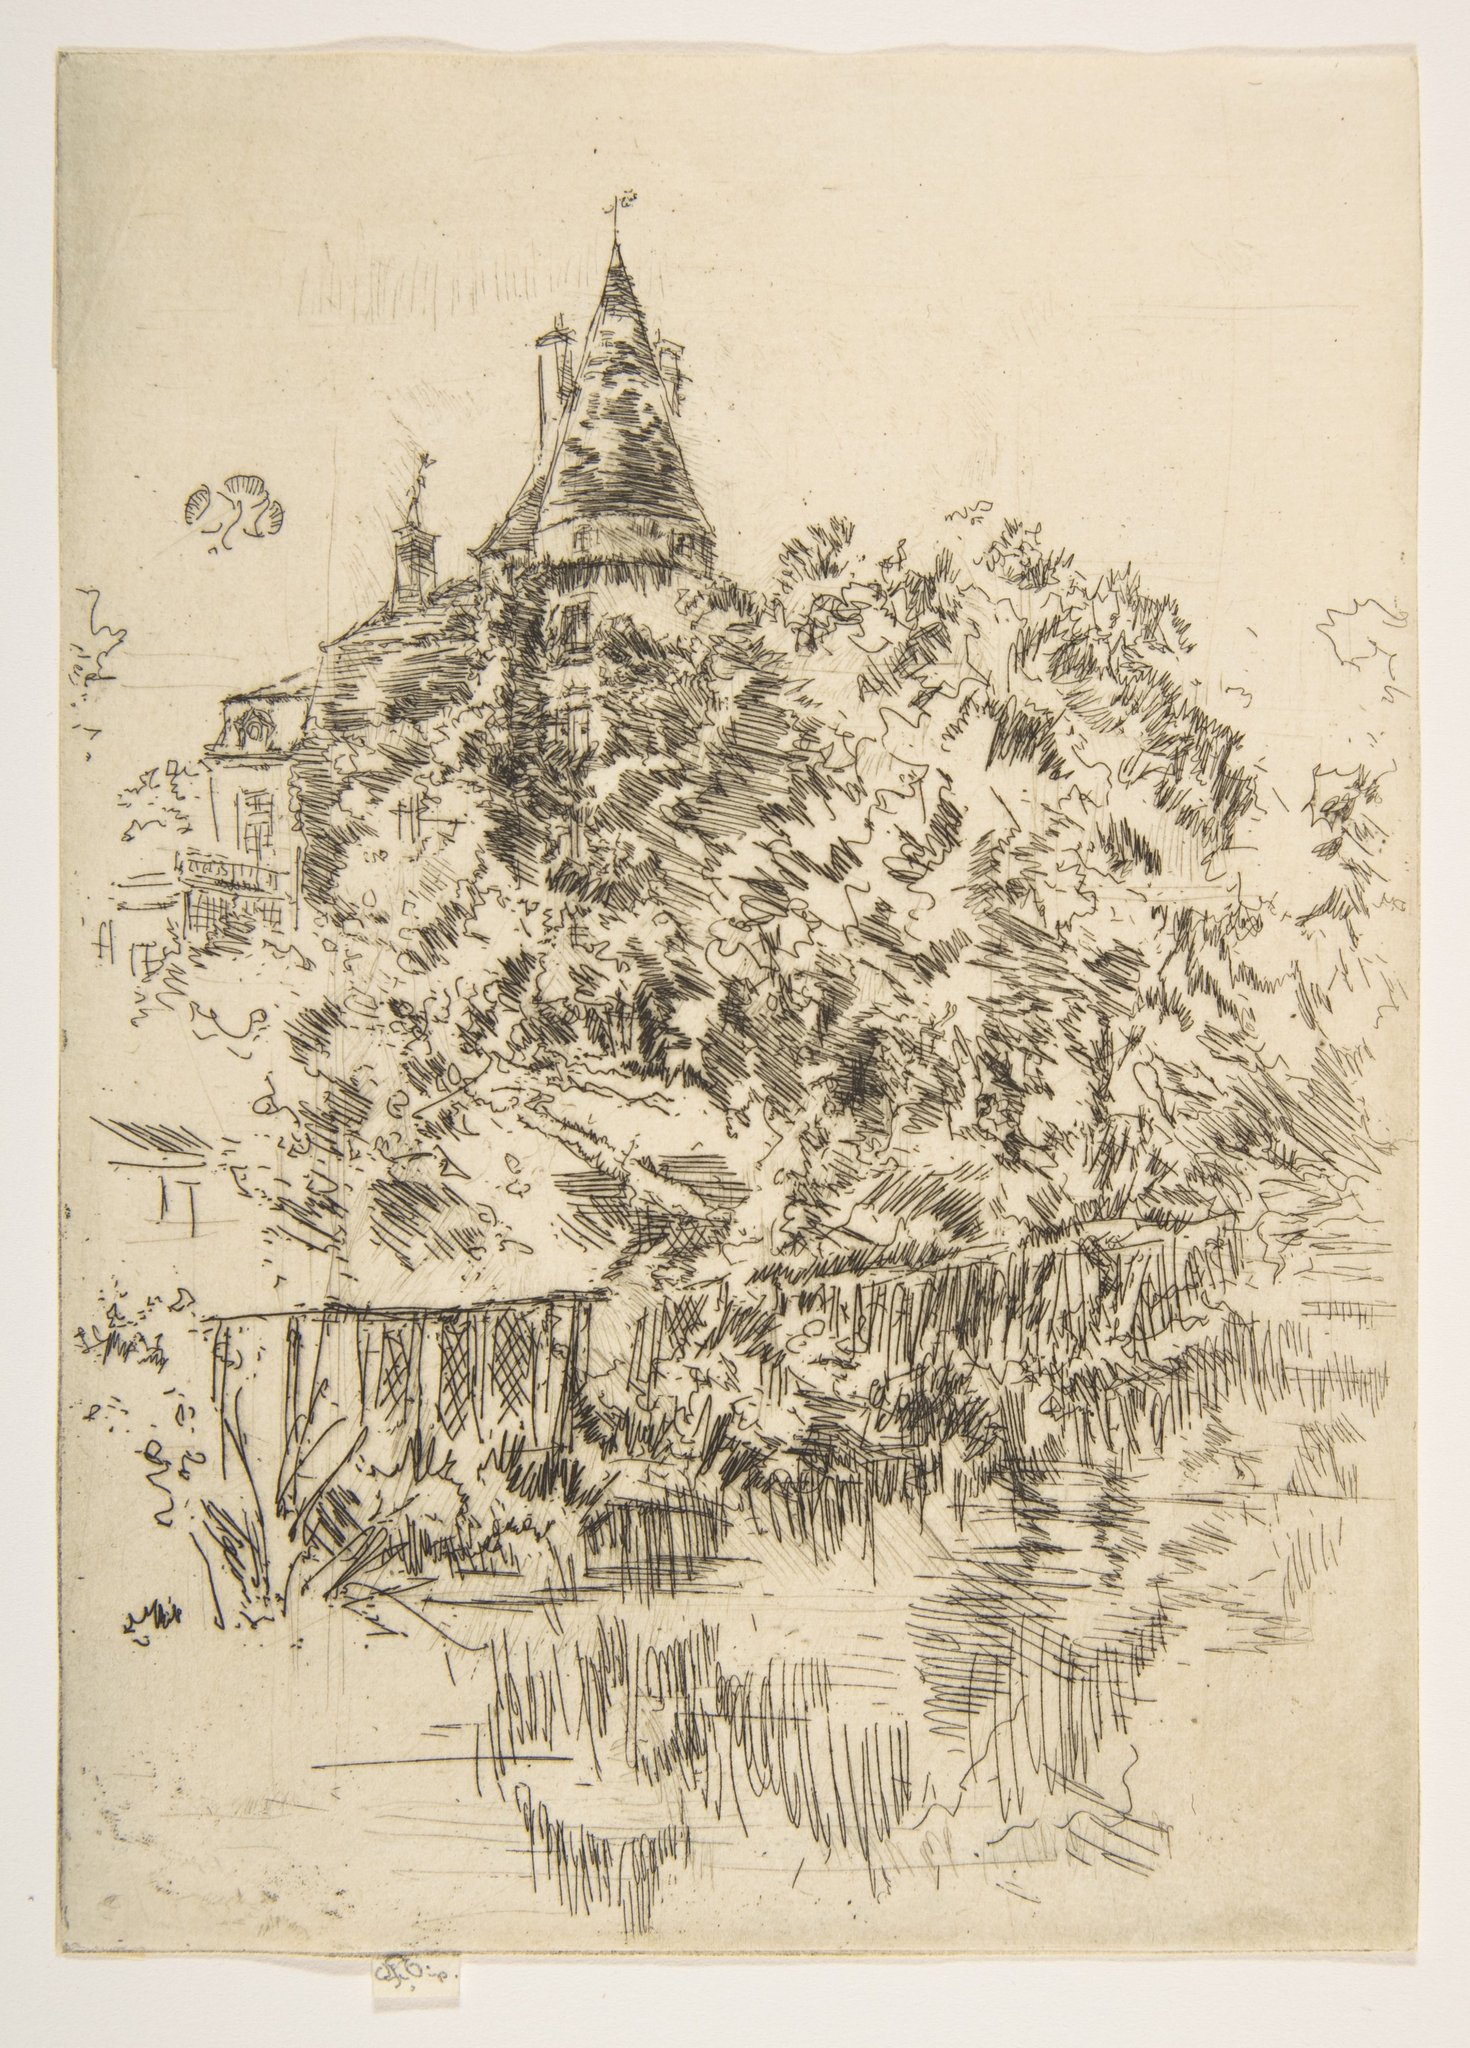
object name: print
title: Château de Verneuil, Touraine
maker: james mcneill whistler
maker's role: artist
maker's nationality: american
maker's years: 1834-1903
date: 1888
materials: ink, ivory, paper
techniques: drypoint, etching, printing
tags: castles,trees